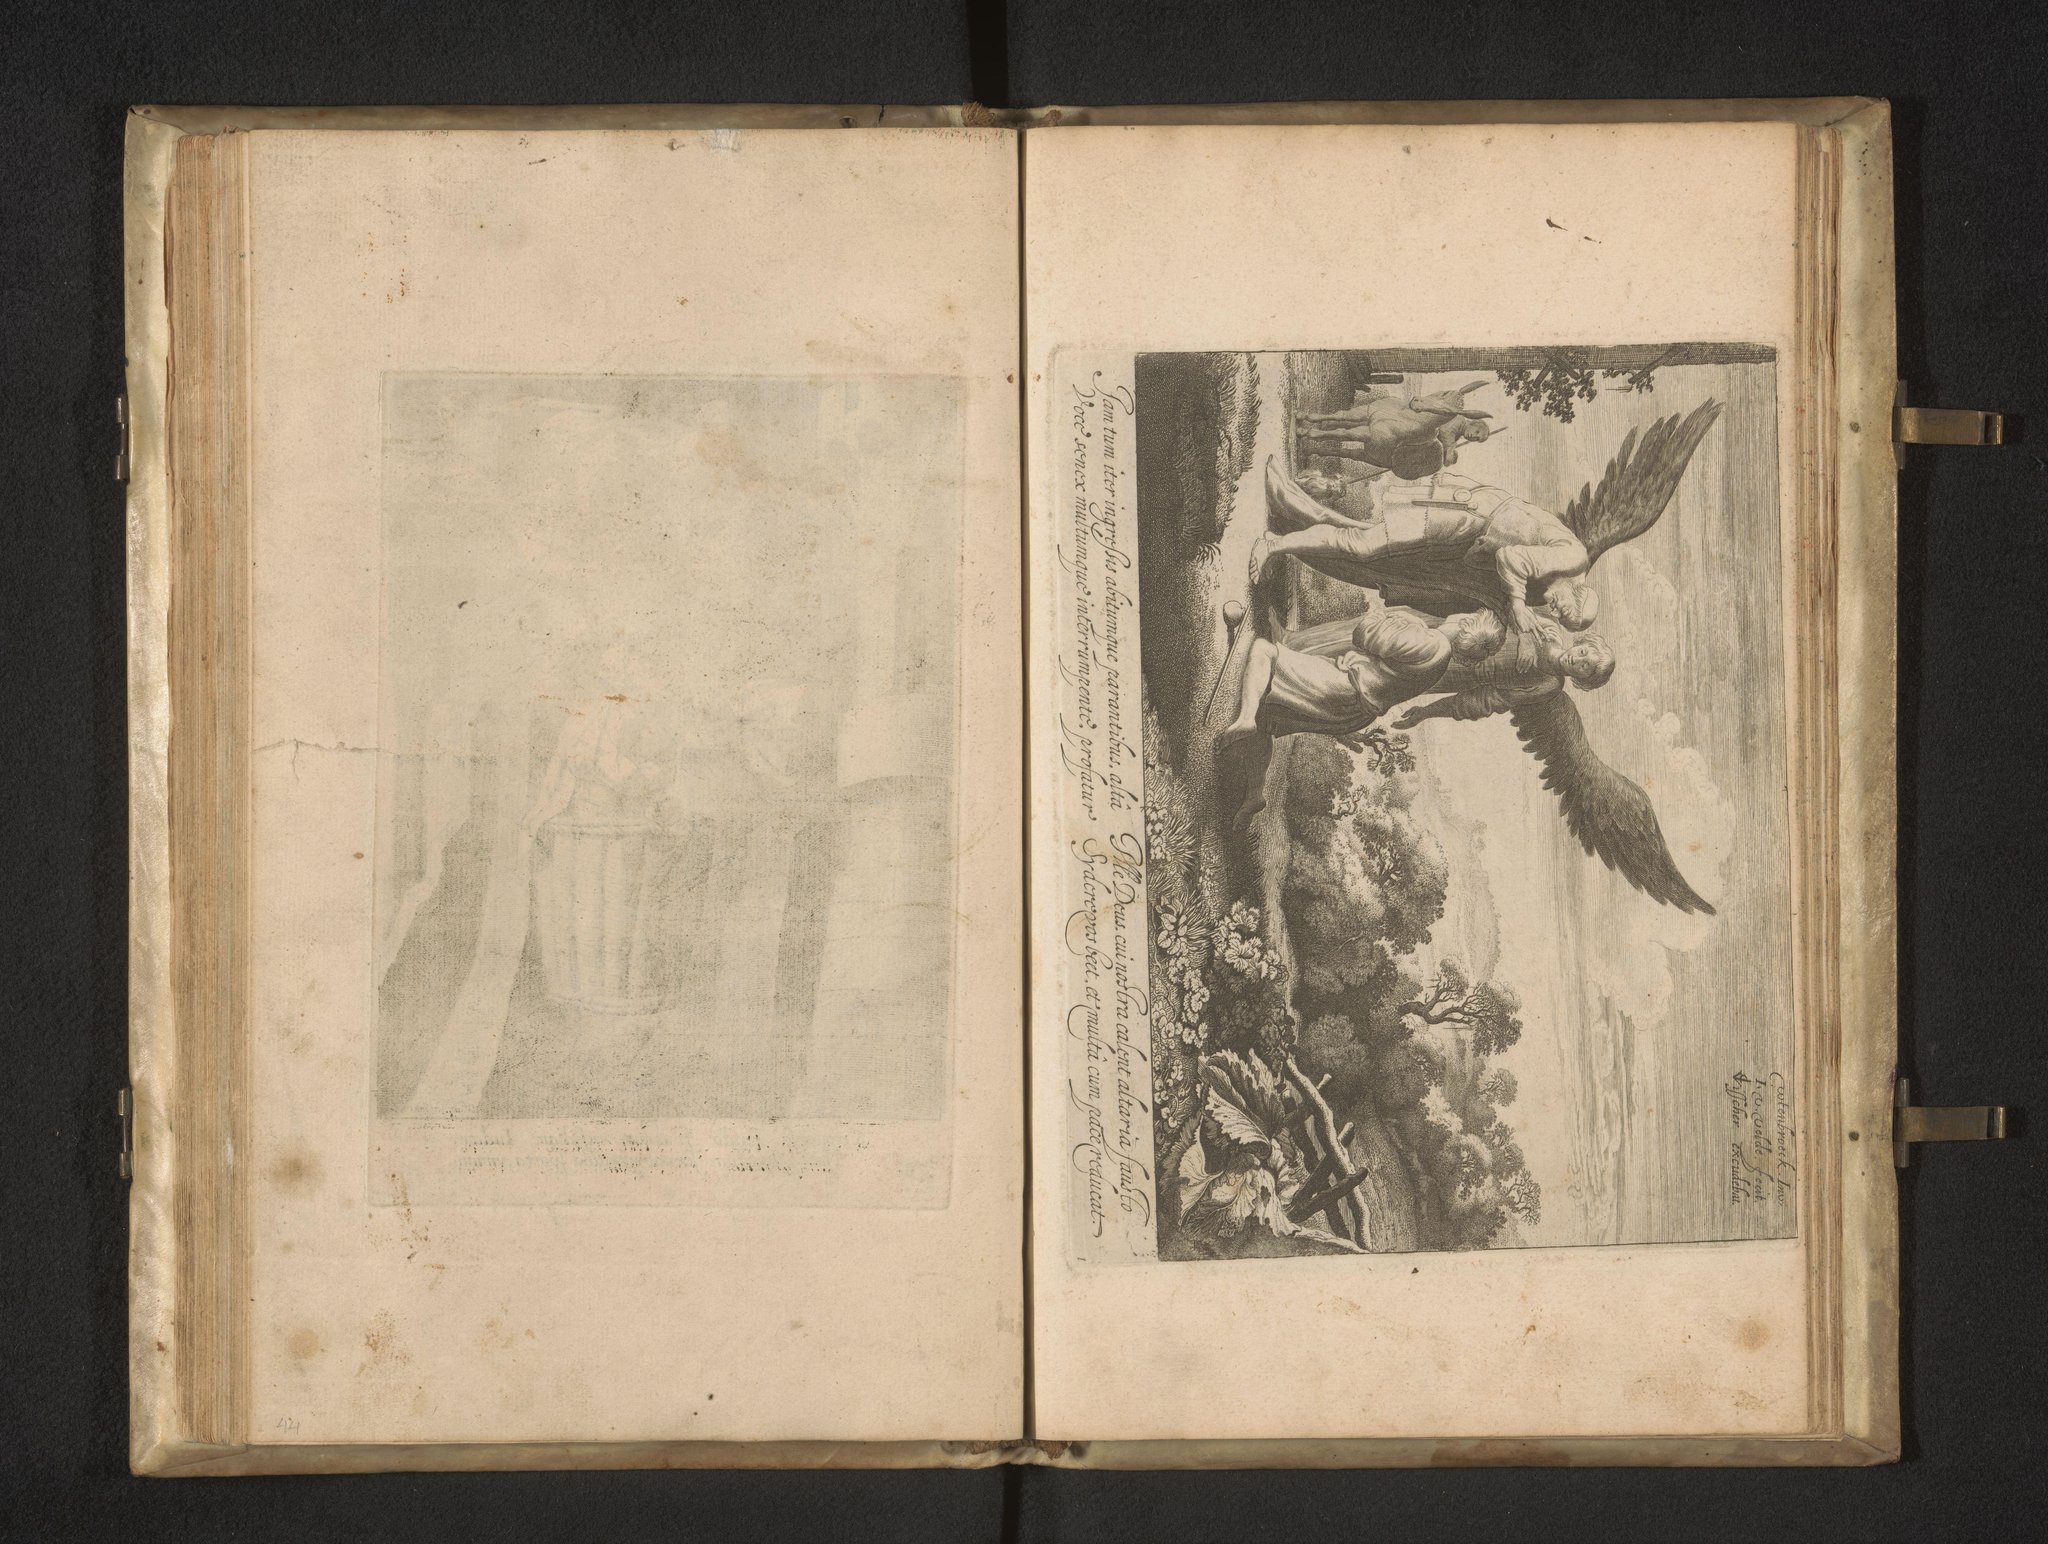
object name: print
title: Tobias gezegend door de blinde Tobit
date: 1603-1641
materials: paper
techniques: engraving, etching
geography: northern netherlands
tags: tobias and the angel raphael with tobit (and anna)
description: Tobit zegent zijn zoon Tobias voordat hij op reis vertrekt met de engel Rafaël. Eerste prent uit een serie van vier over het bijbelverhaal van Tobias. Rechtsonder genummerd: 1. Onderaan in de marge een onderschrift van vier regels in het Latijn. Onderdeel van een album met voornamelijk christelijke voorstellingen.